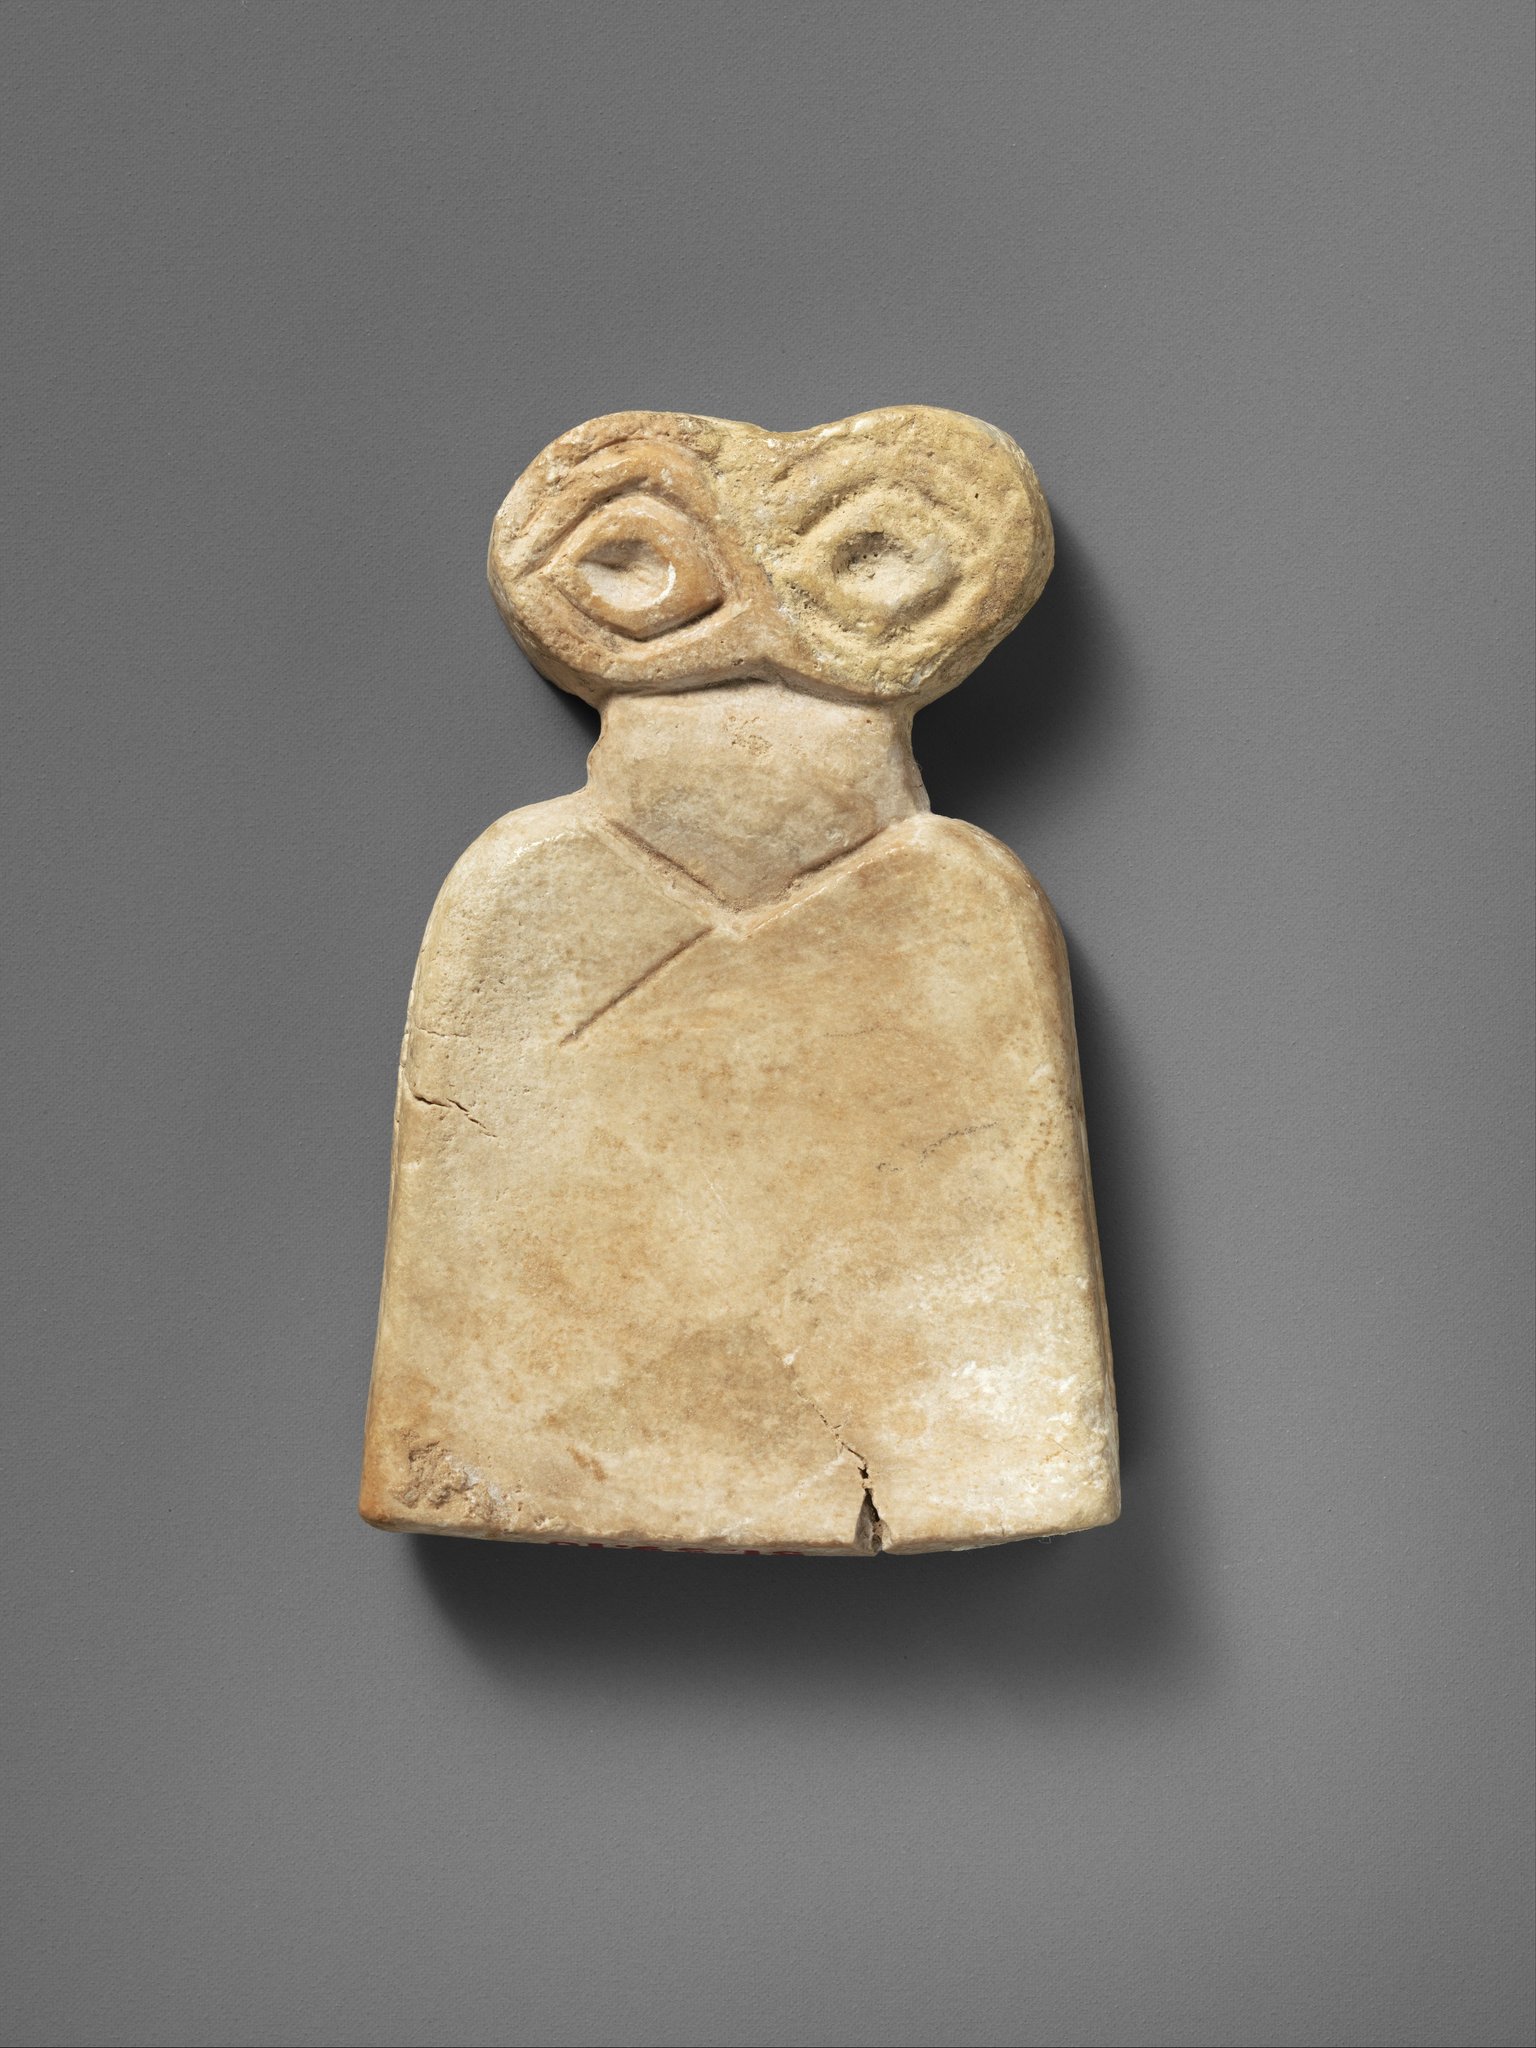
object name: sculpture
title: Eye idol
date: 3700-3500 BCE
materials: alabaster, gypsum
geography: syria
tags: eyes